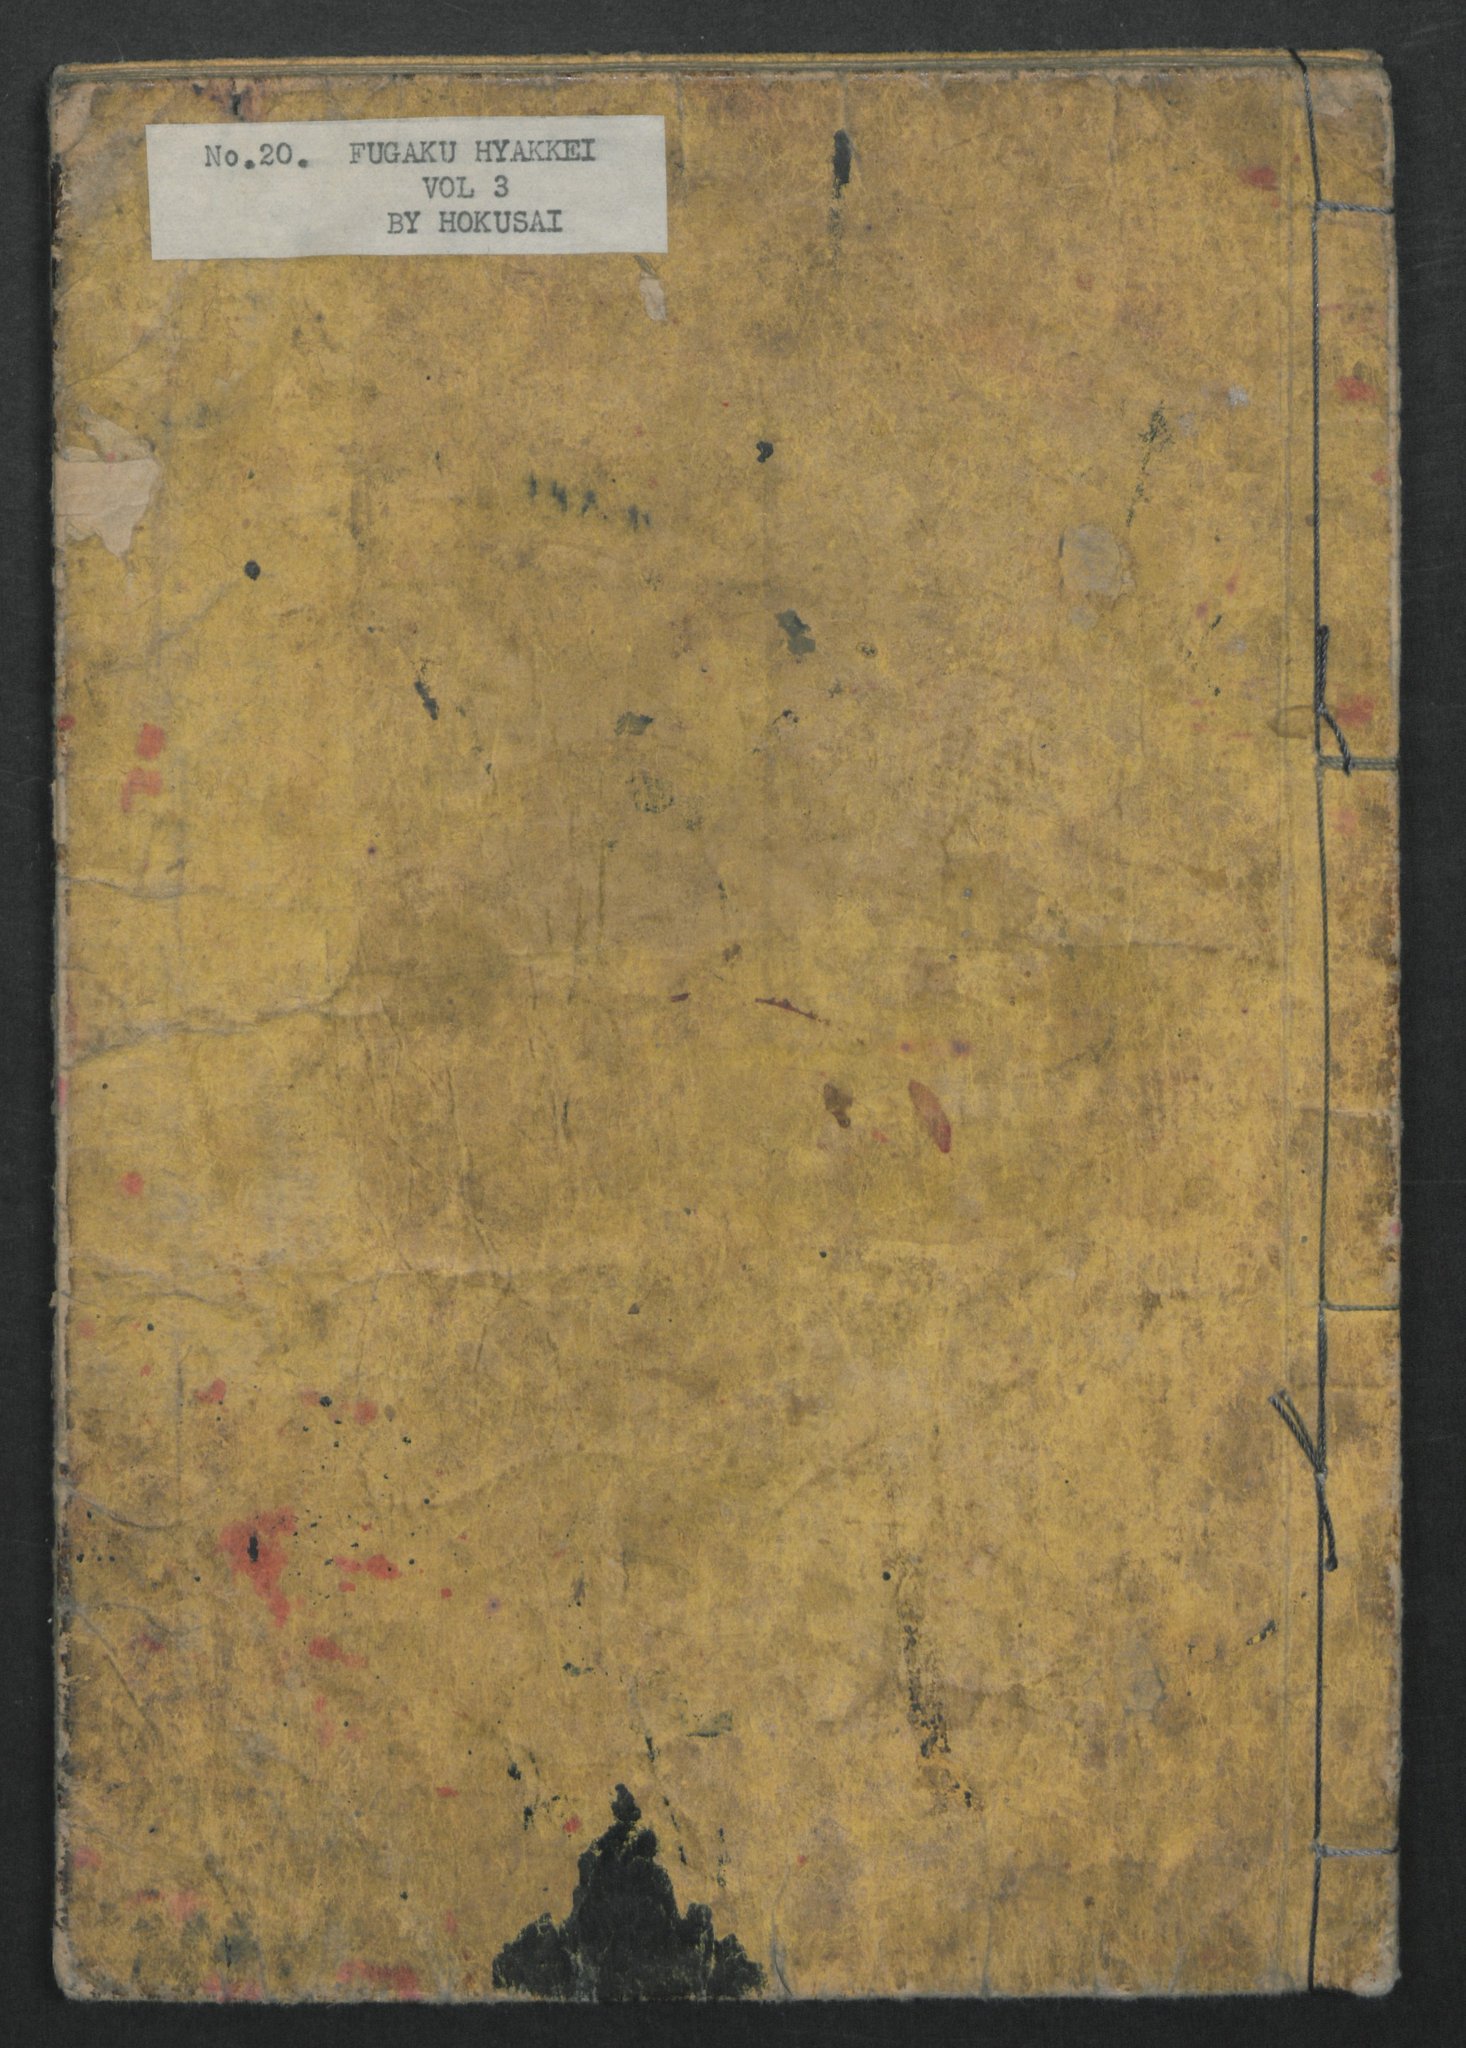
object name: illustrated book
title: One Hundred Views of Mount Fuji (Fugaku Hyakkei sanpen) 富嶽百景[三編]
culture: japanese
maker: katsushika hokusai 葛飾北斎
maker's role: artist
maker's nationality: japanese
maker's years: 1760-1849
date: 1847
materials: ink, paper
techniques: woodblock print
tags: human figures,bridges,mountains,trees